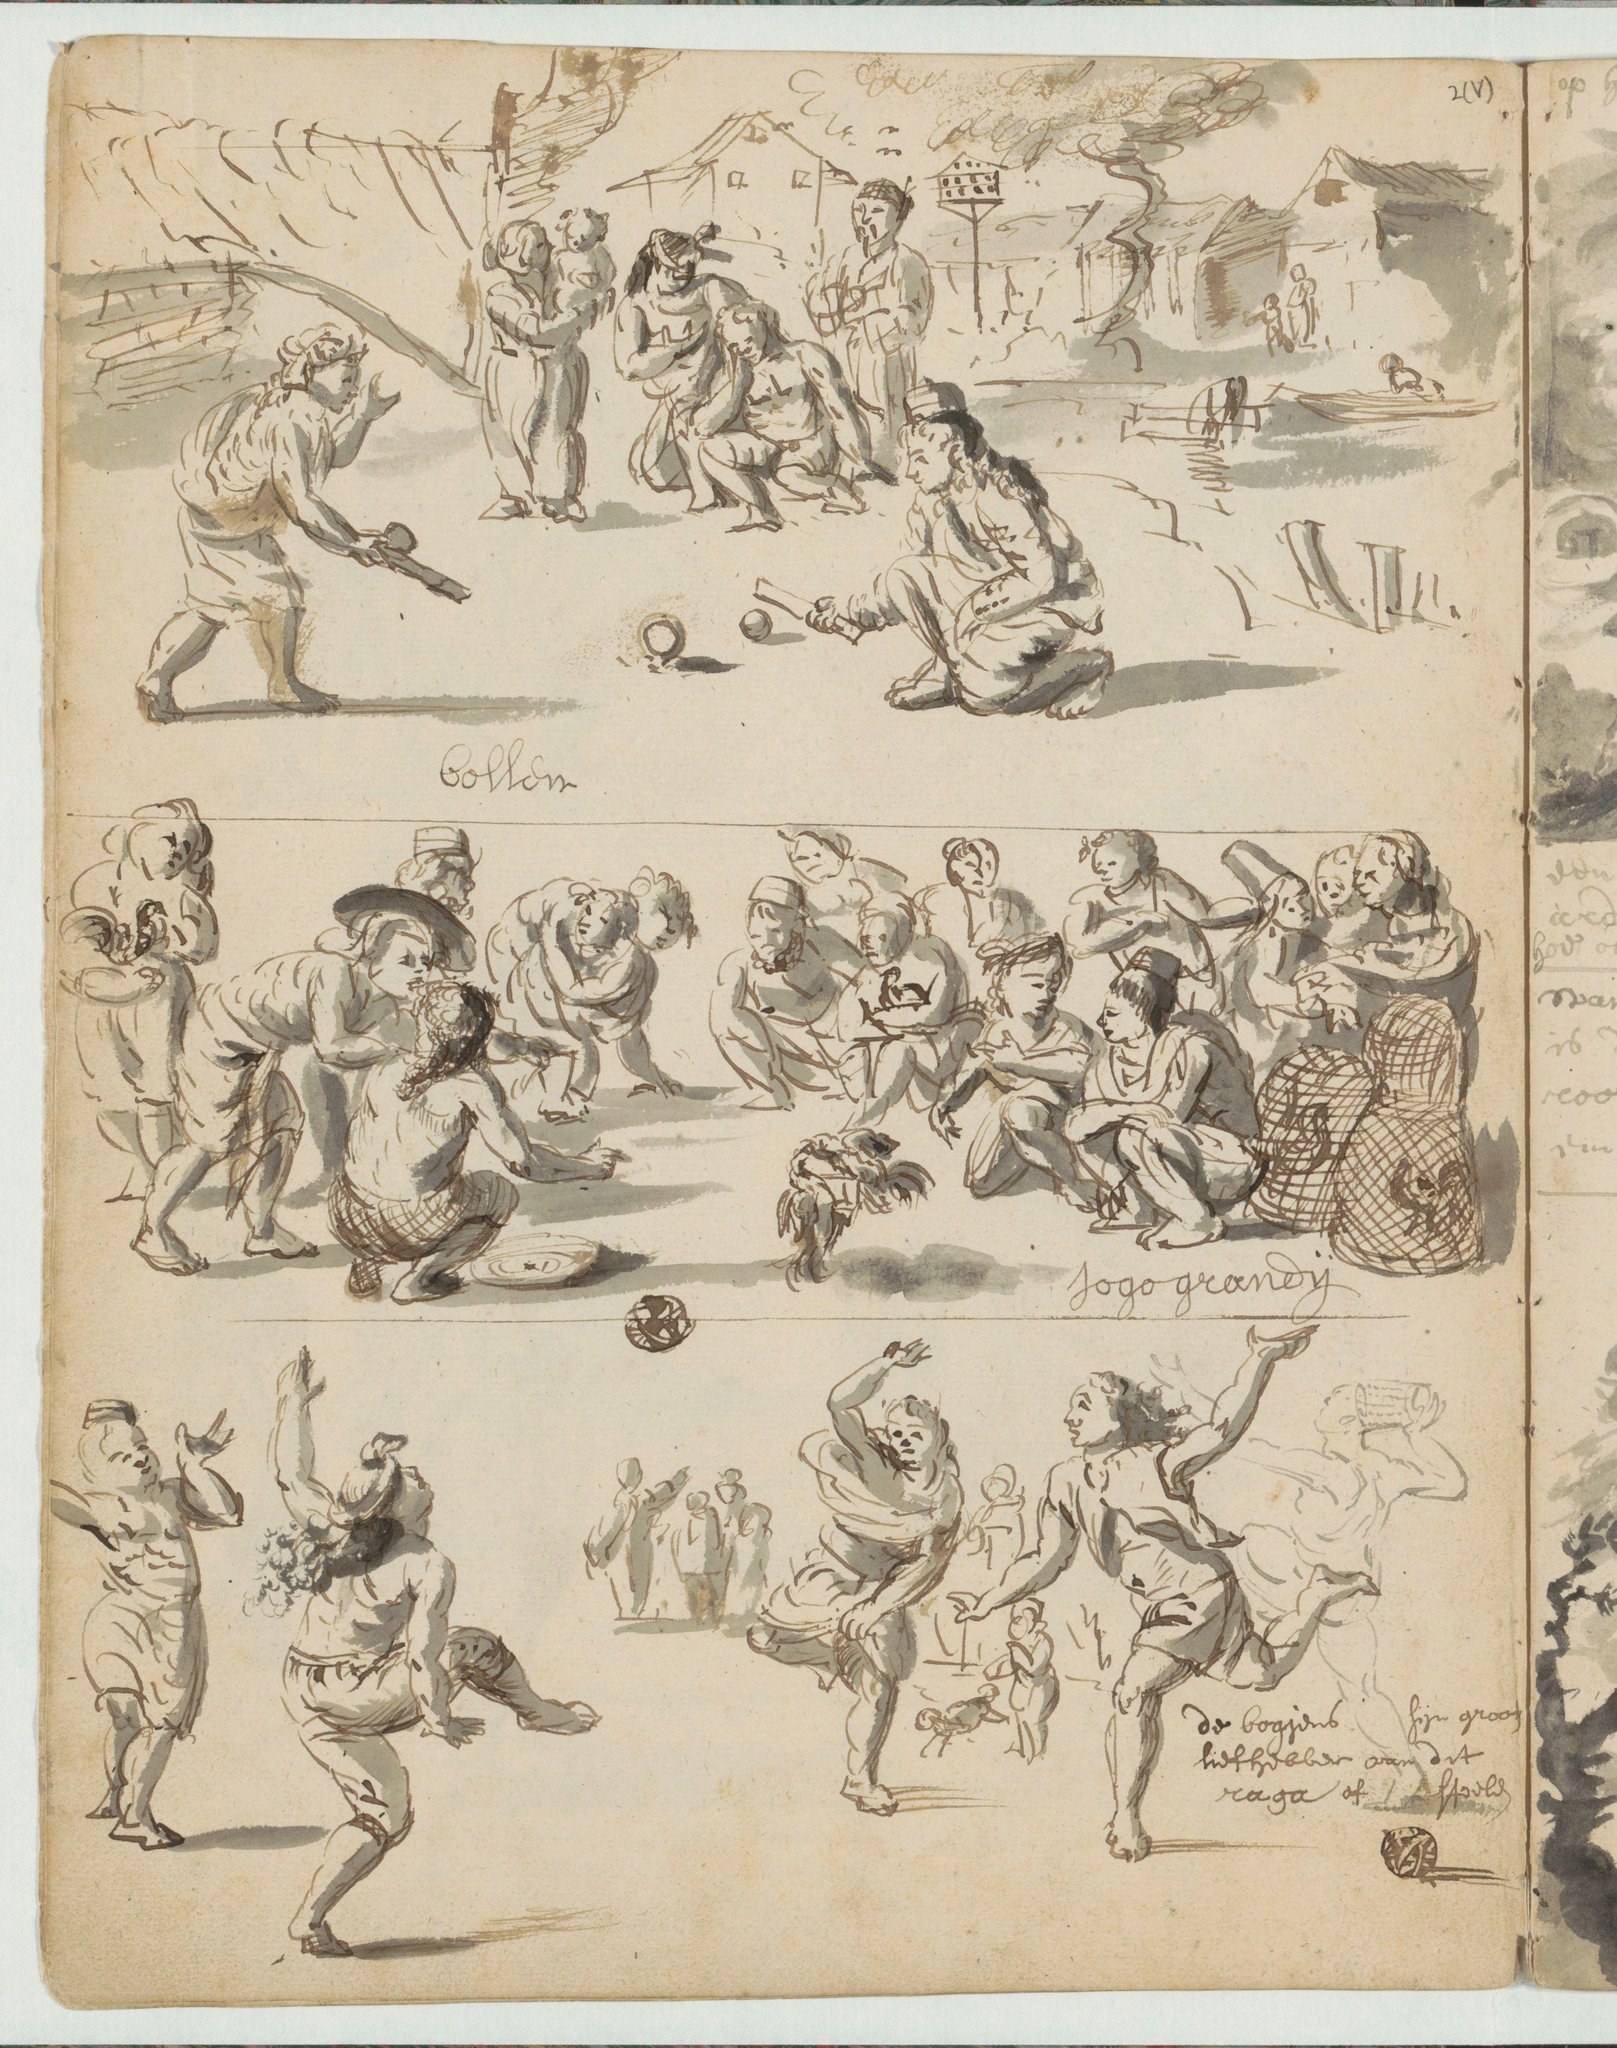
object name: sketchbook leaf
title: Groepen die balspellen spelen en toeschouwers van een hanengevecht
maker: wouter schouten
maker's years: 1638-1704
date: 1660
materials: ink, paper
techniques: brush, pen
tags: asiatic races and peoples (indonesians), asiatic races and peoples (with name), ball games, cock-fighting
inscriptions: annotation: ‘Gollon/ Jogo grandij/ do bogj[...] fijn groo[...]/ [...]’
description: Studies van een straat met figuren die een balspel spelen en van gehurkte figuren in een halve cirkel die naar een hanengevecht kijken. Onderaan het blad figuren die hun armen en benen in de lucht gooien. Mogelijk dansen zij of spelen ze een balspel. Blad 2 verso van een katern van 10 bladen afkomstig uit een schetsboek.